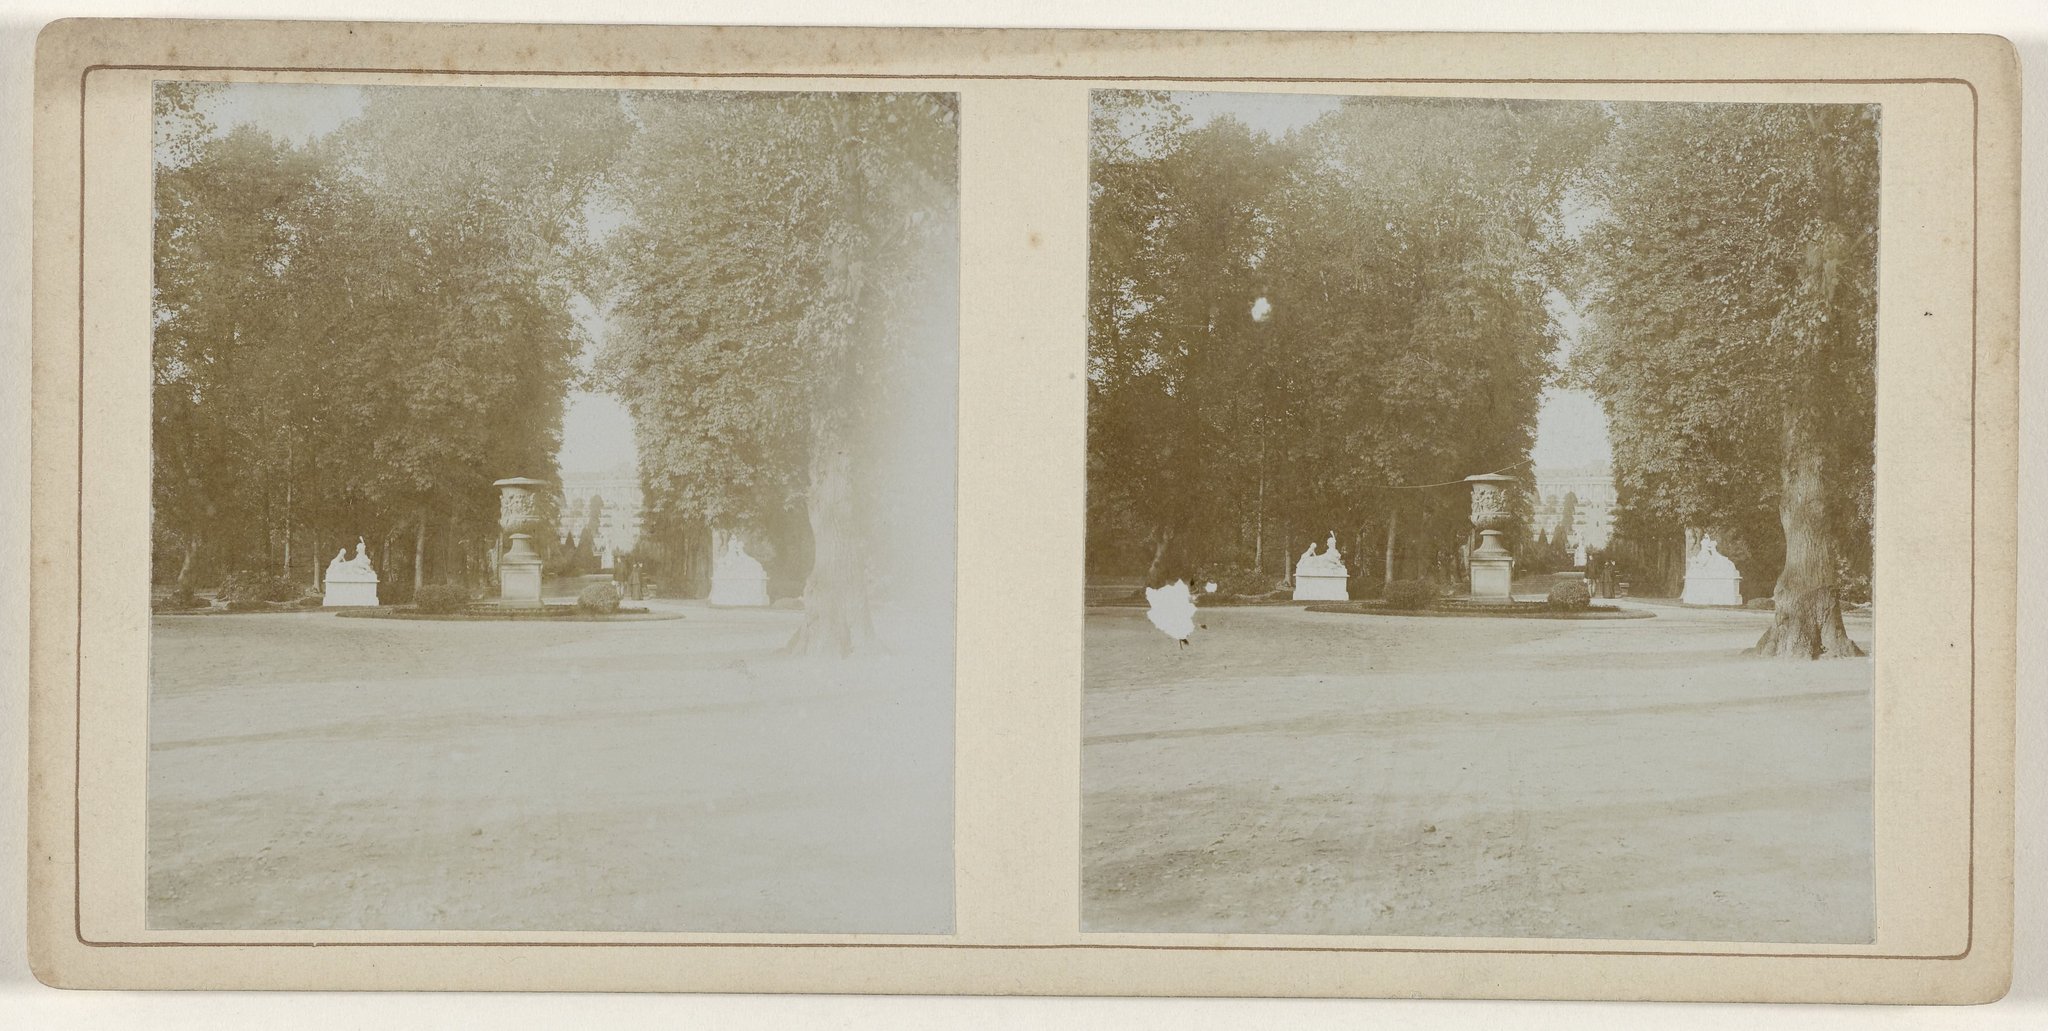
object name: stereograph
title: In 't Potsdammer park. Kont Bijou, paleis van de grooten keurvorst van voren gezien. Oct 1903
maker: geldolph adriaan kessler (dolph)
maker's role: fotograaf, industrieel, voetballer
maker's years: 1884-1945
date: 1903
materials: paper, photographic support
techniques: collodion silver print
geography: hamburg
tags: potsdam